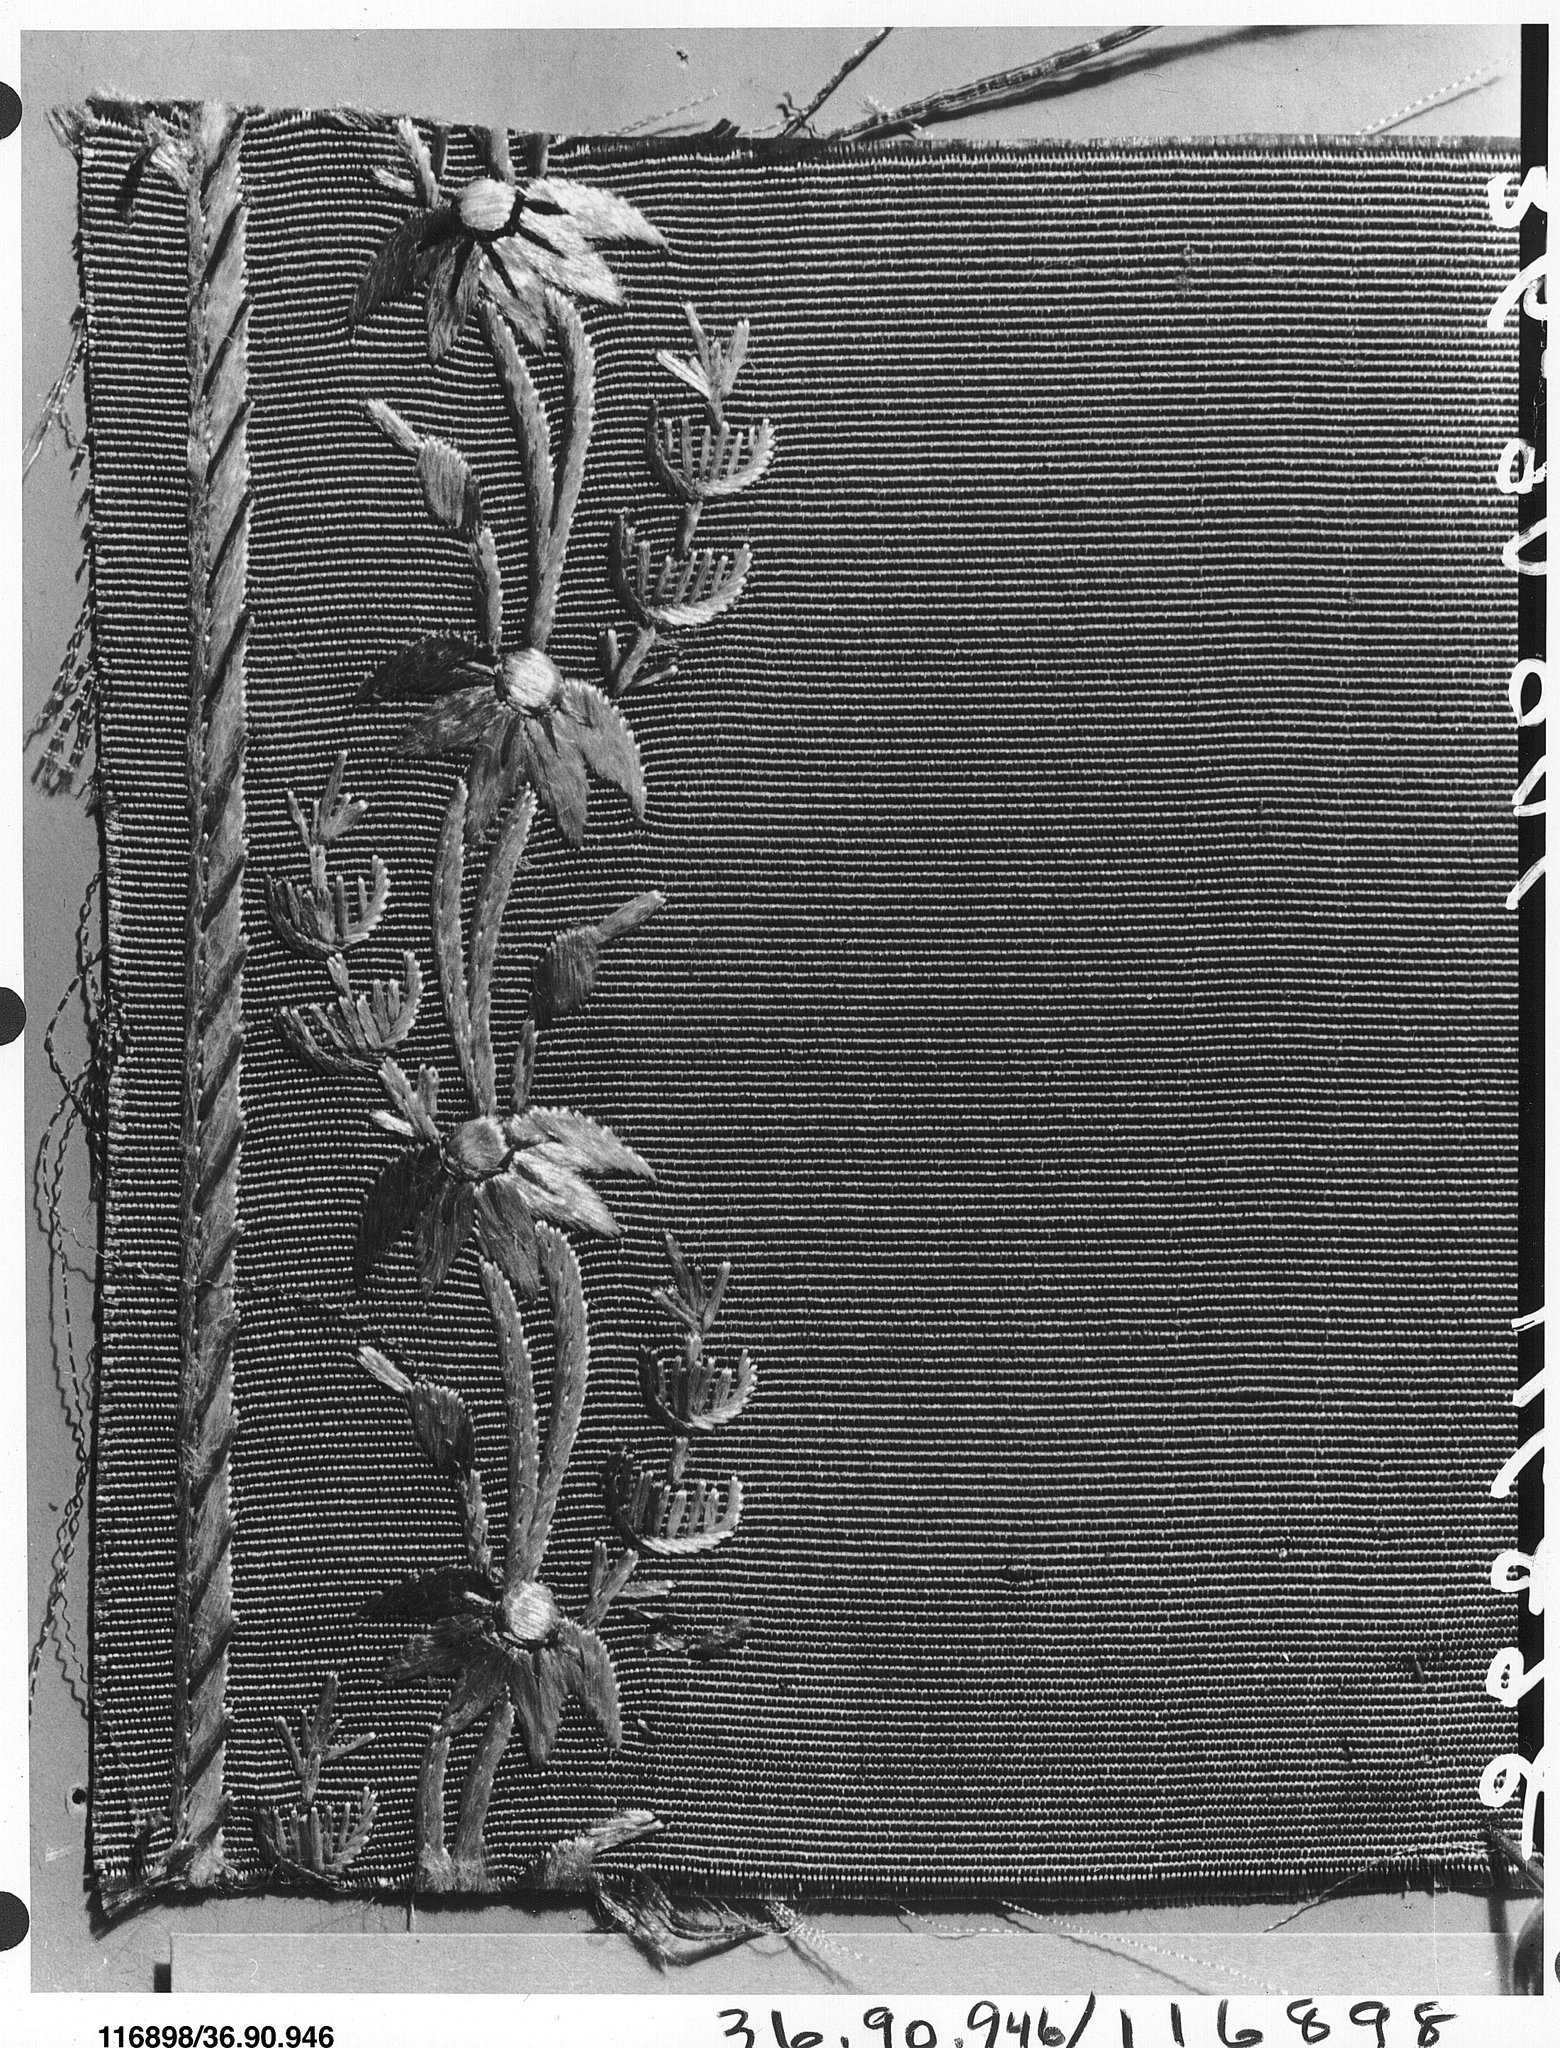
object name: sample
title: Embroidery sample for a man’s suit or waistcoat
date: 1785-1820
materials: silk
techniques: embroidery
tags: flowers